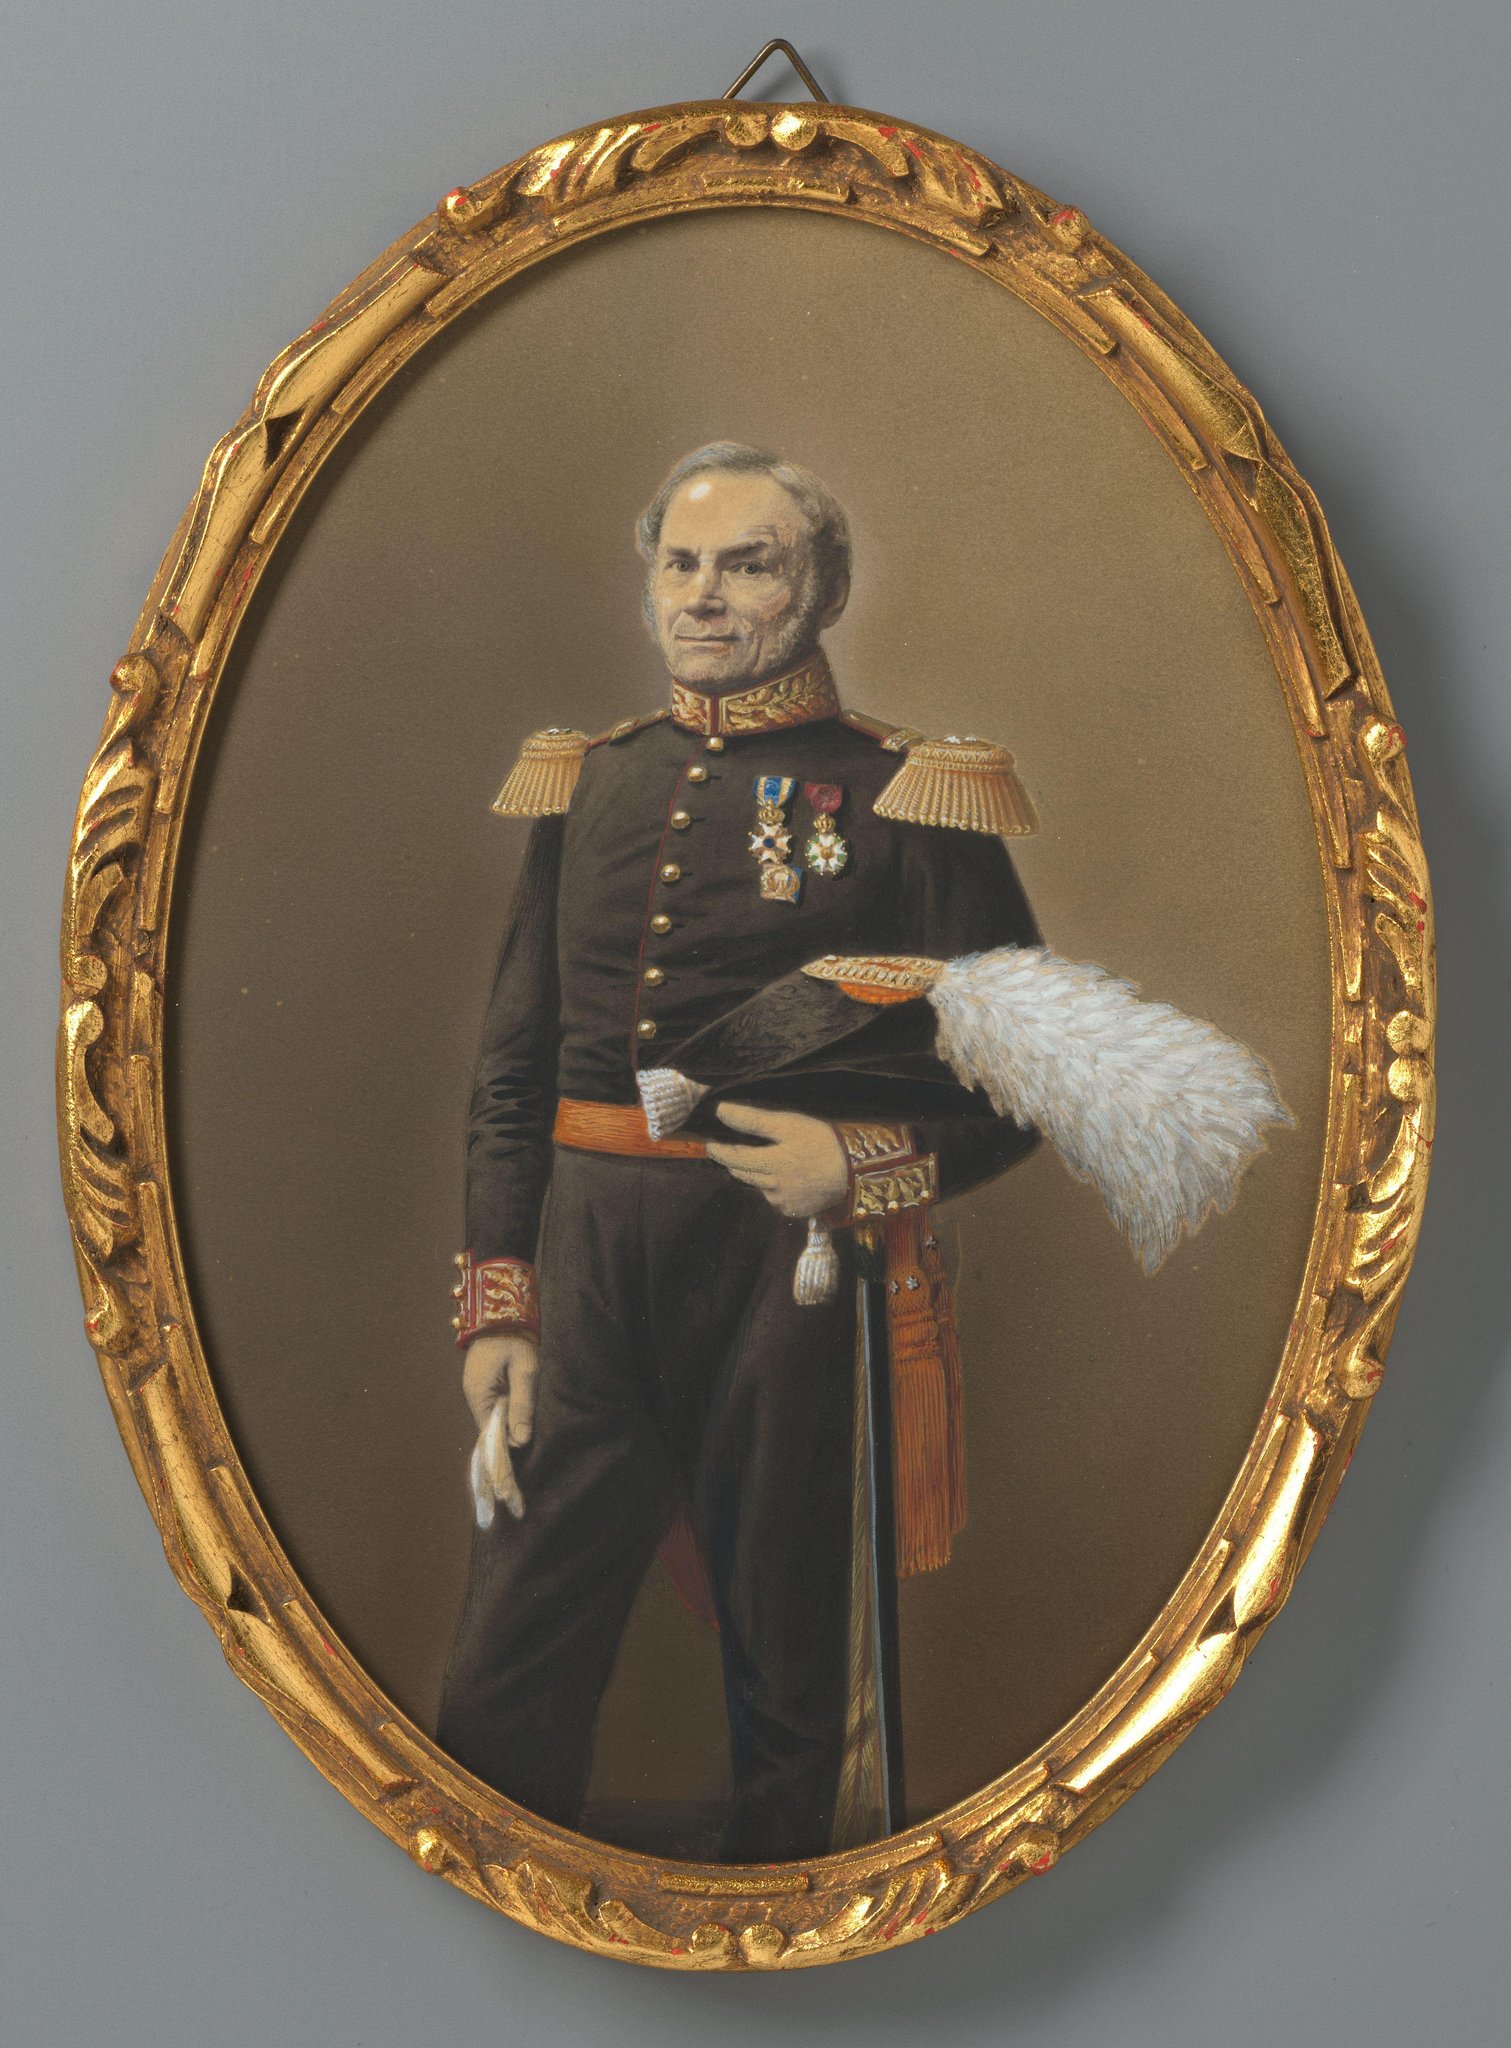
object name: photograph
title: Portret van de gouverneur generaal van Suriname, Reinier Frederik Baron van Raders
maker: Anonymous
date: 1852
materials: cardboard, gouache, paper, photographic support, watercolor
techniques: aquarelle, salted paper print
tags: reinier frederik baron van raders